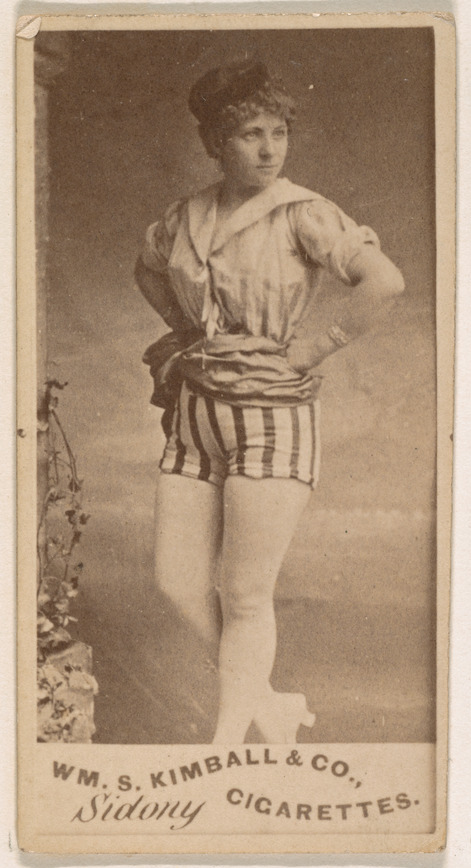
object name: photograph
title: Miss Sidony, from the Actresses series (N203) issued by Wm. S. Kimball & Co.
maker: william s. kimball & company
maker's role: publisher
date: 1889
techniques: color lithograph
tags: portraits,women,actresses